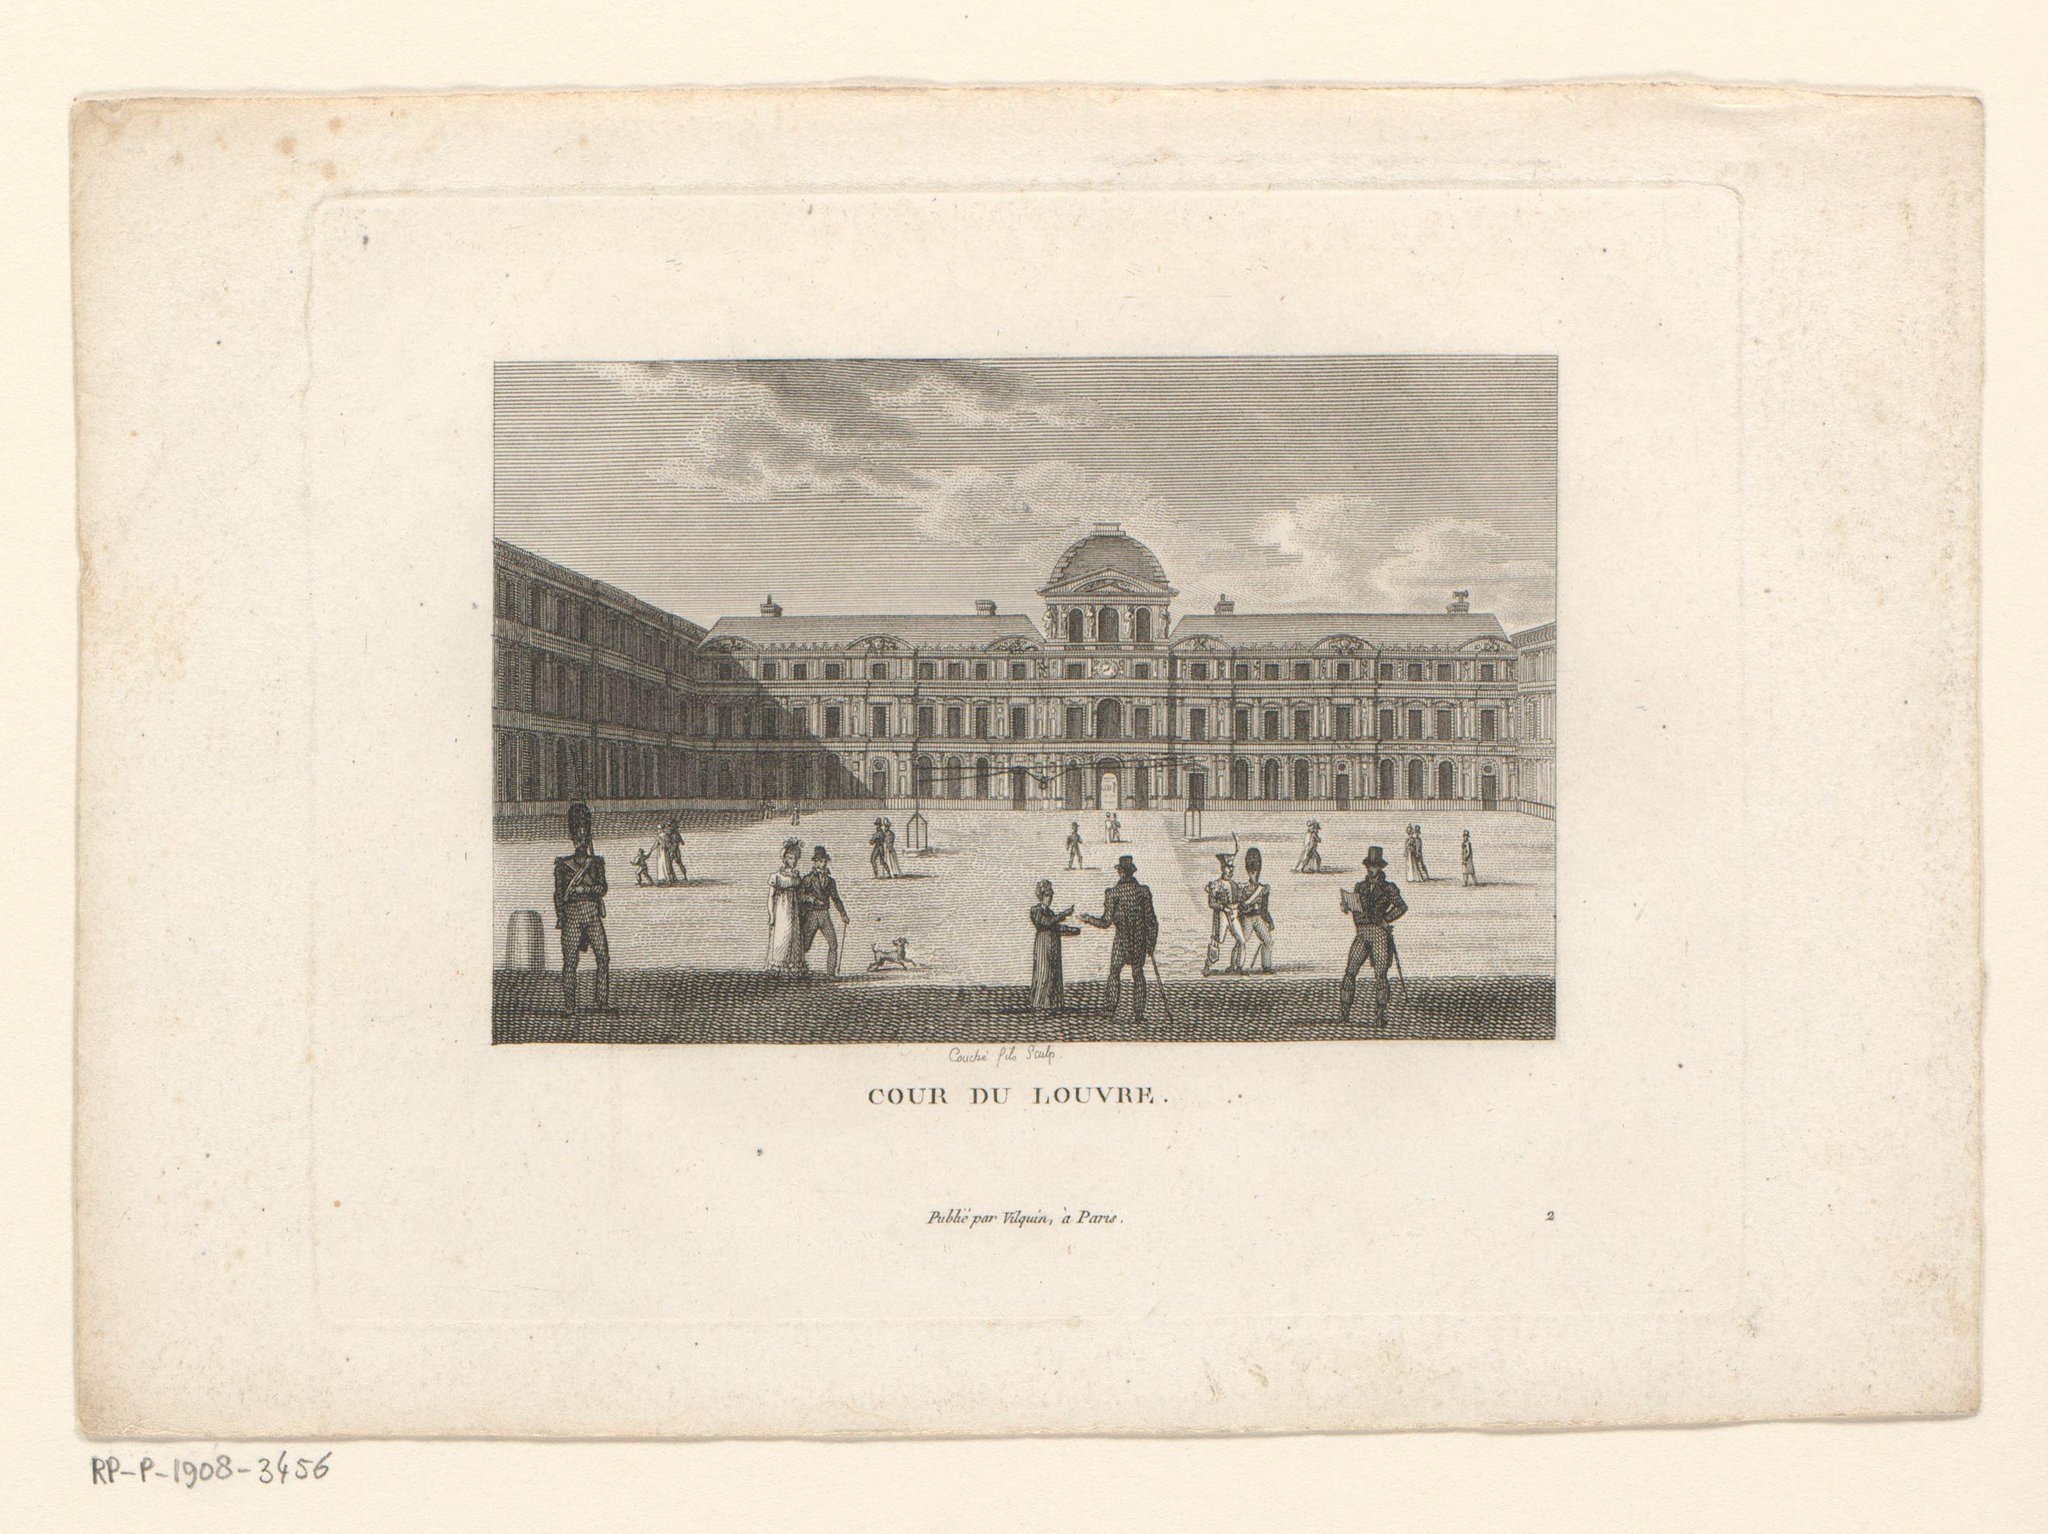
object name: print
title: Cour du Louvre.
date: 1818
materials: paper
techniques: etching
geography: paris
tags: city-view in general; 'veduta', palace, paris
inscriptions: collector's mark: Lugt 2228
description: Maakt deel uit van een serie met 60 platen van monumenten, kathedralen en paleizen in Parijs.